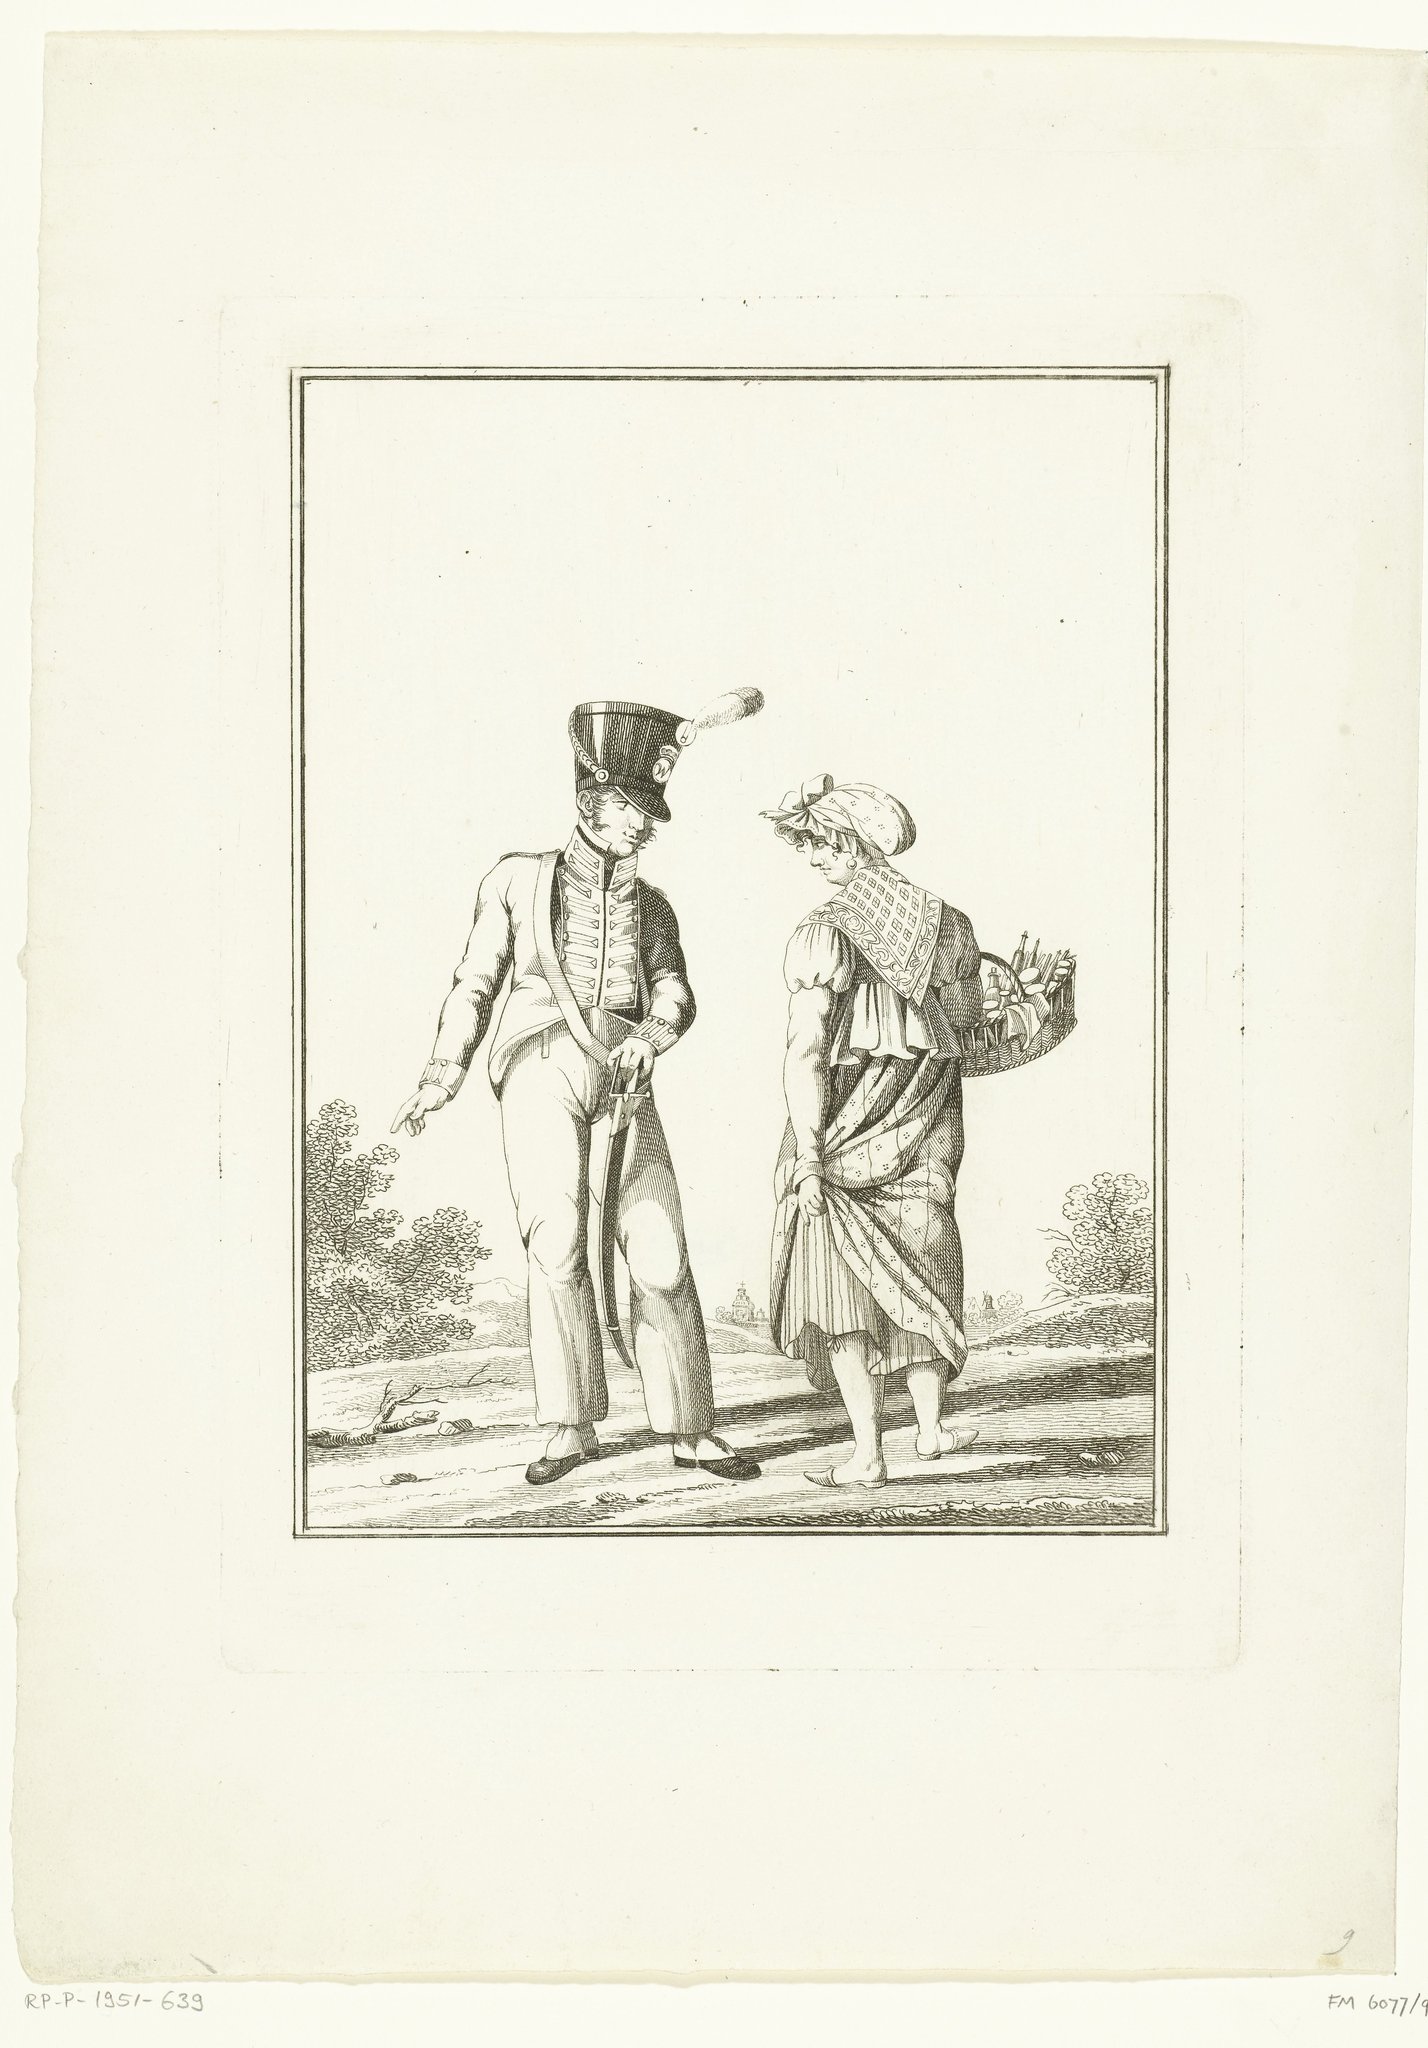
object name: print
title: Uniformen en klederdrachten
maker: joannes bemme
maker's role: print maker, printer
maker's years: 1775-1841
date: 1800-1841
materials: paper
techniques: etching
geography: rotterdam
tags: street-trader - bb - women engaged in trade and commerce, folk costume, regional costume, (military) uniforms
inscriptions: collector's mark: Lugt 2228